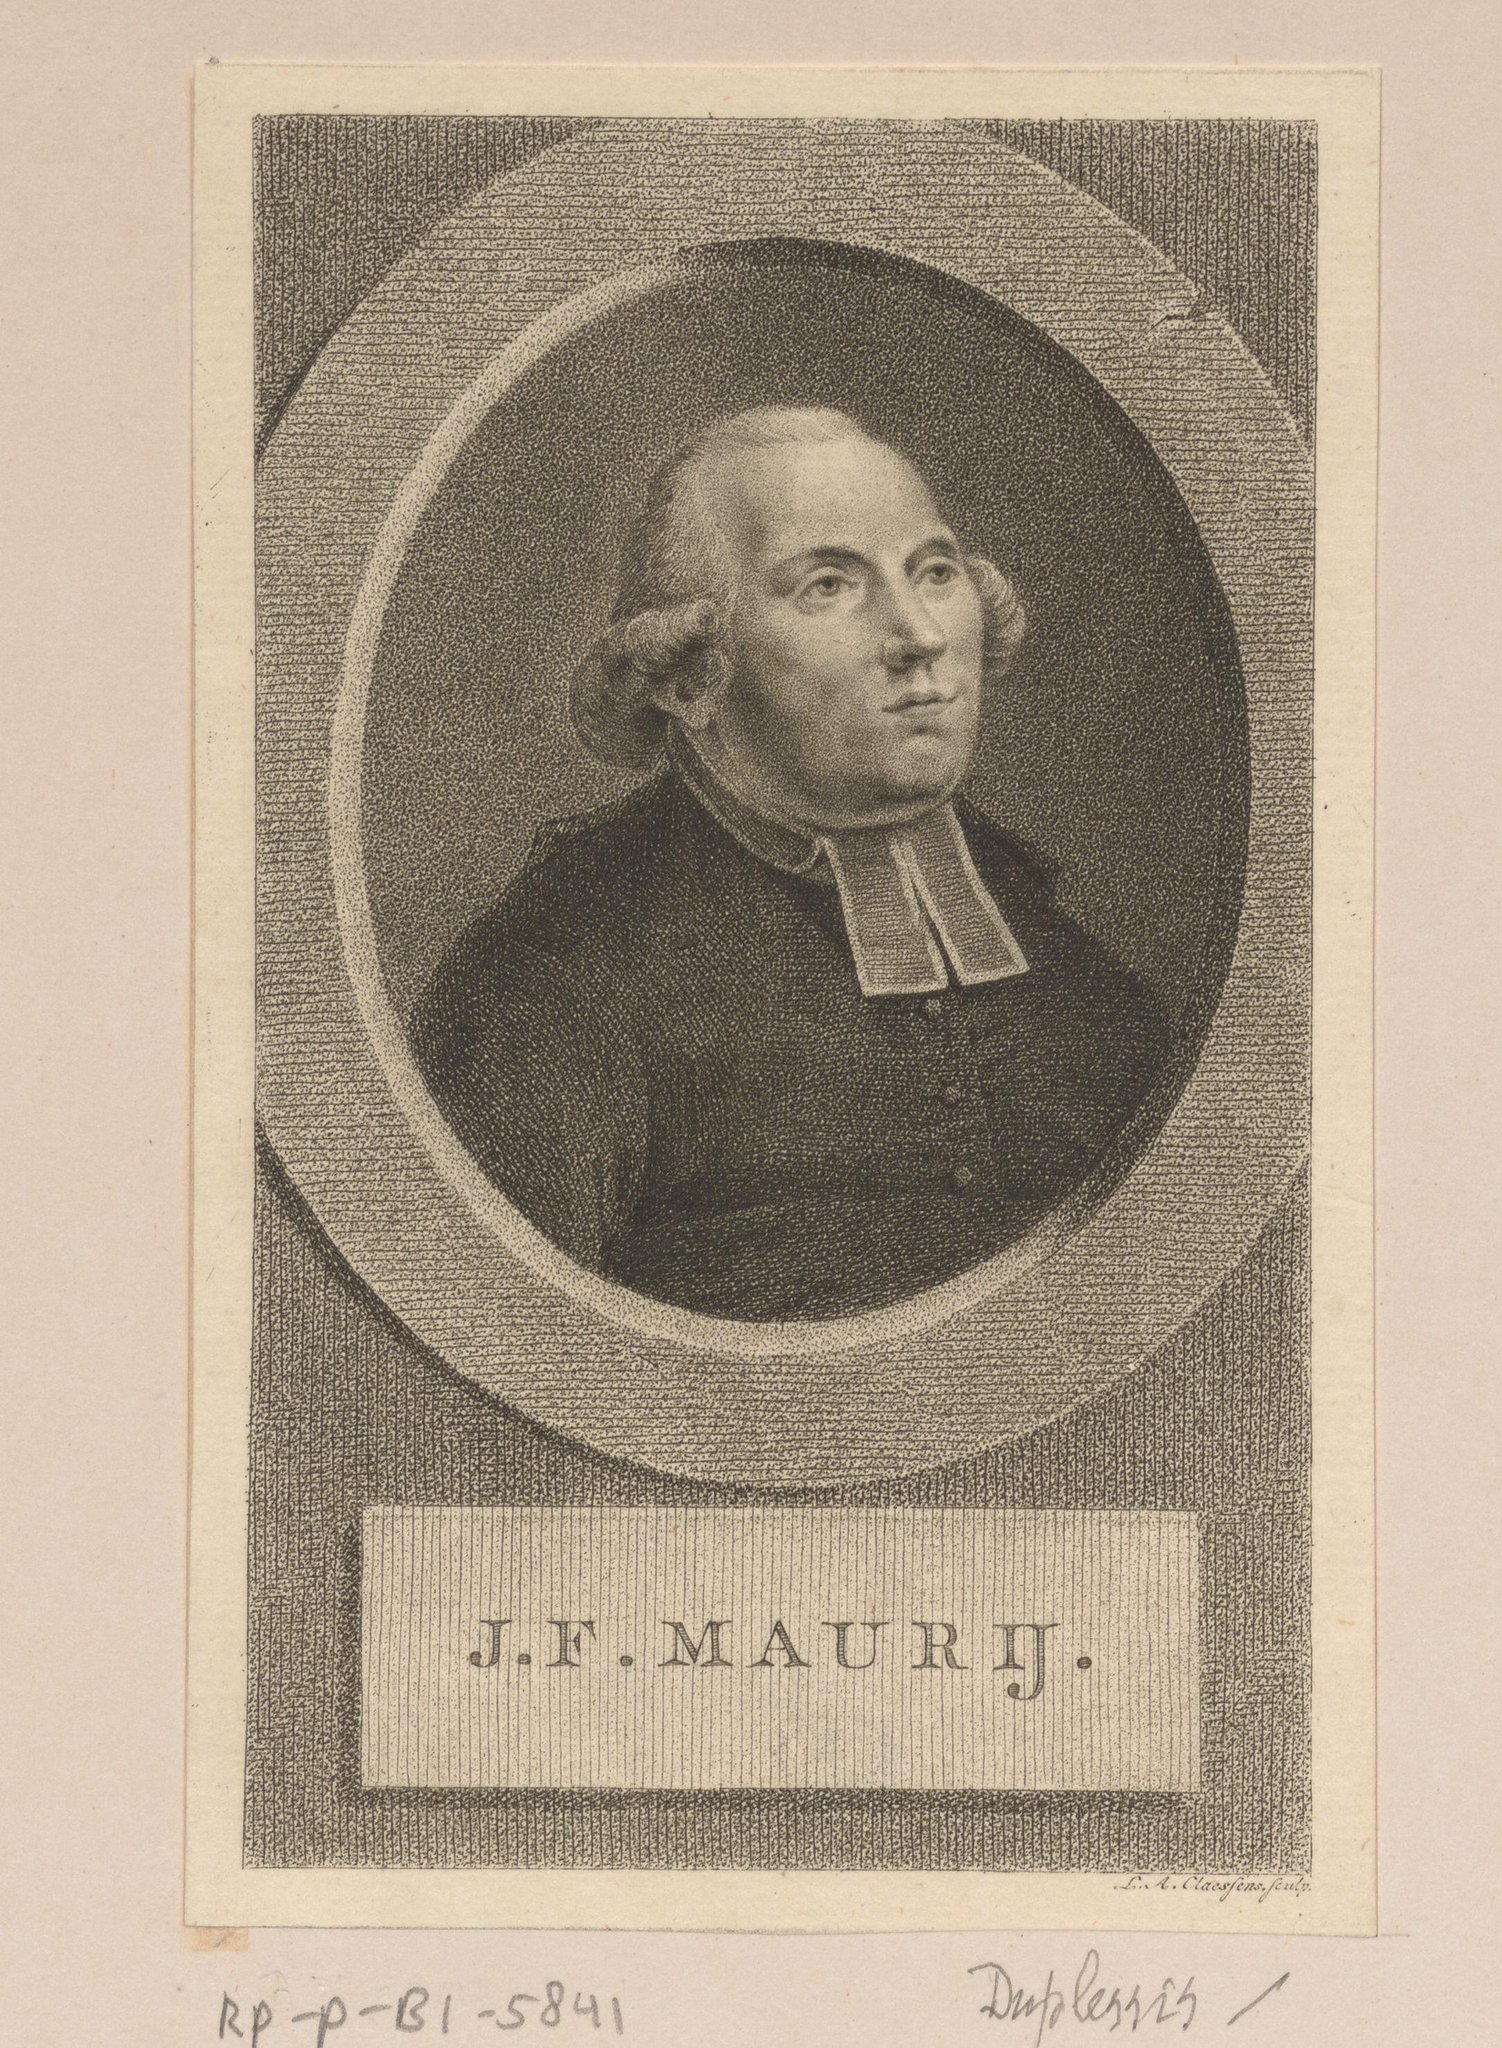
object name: print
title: Portret van Jean Sifrein Maury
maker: lambertus antonius claessens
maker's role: draughtsman, print maker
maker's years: 1763-1834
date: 1797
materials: paper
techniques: engraving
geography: amsterdam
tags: archbishop, bishop, etc. (roman catholic), ornament ~ medallion, historical persons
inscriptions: collector's mark: Lugt 2228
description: Prent waarschijnlijk uit: Tafereelen van de staatsomwenteling in Frankrijk. Amsterdam: Johannes Allart, 1797, dl. 5.